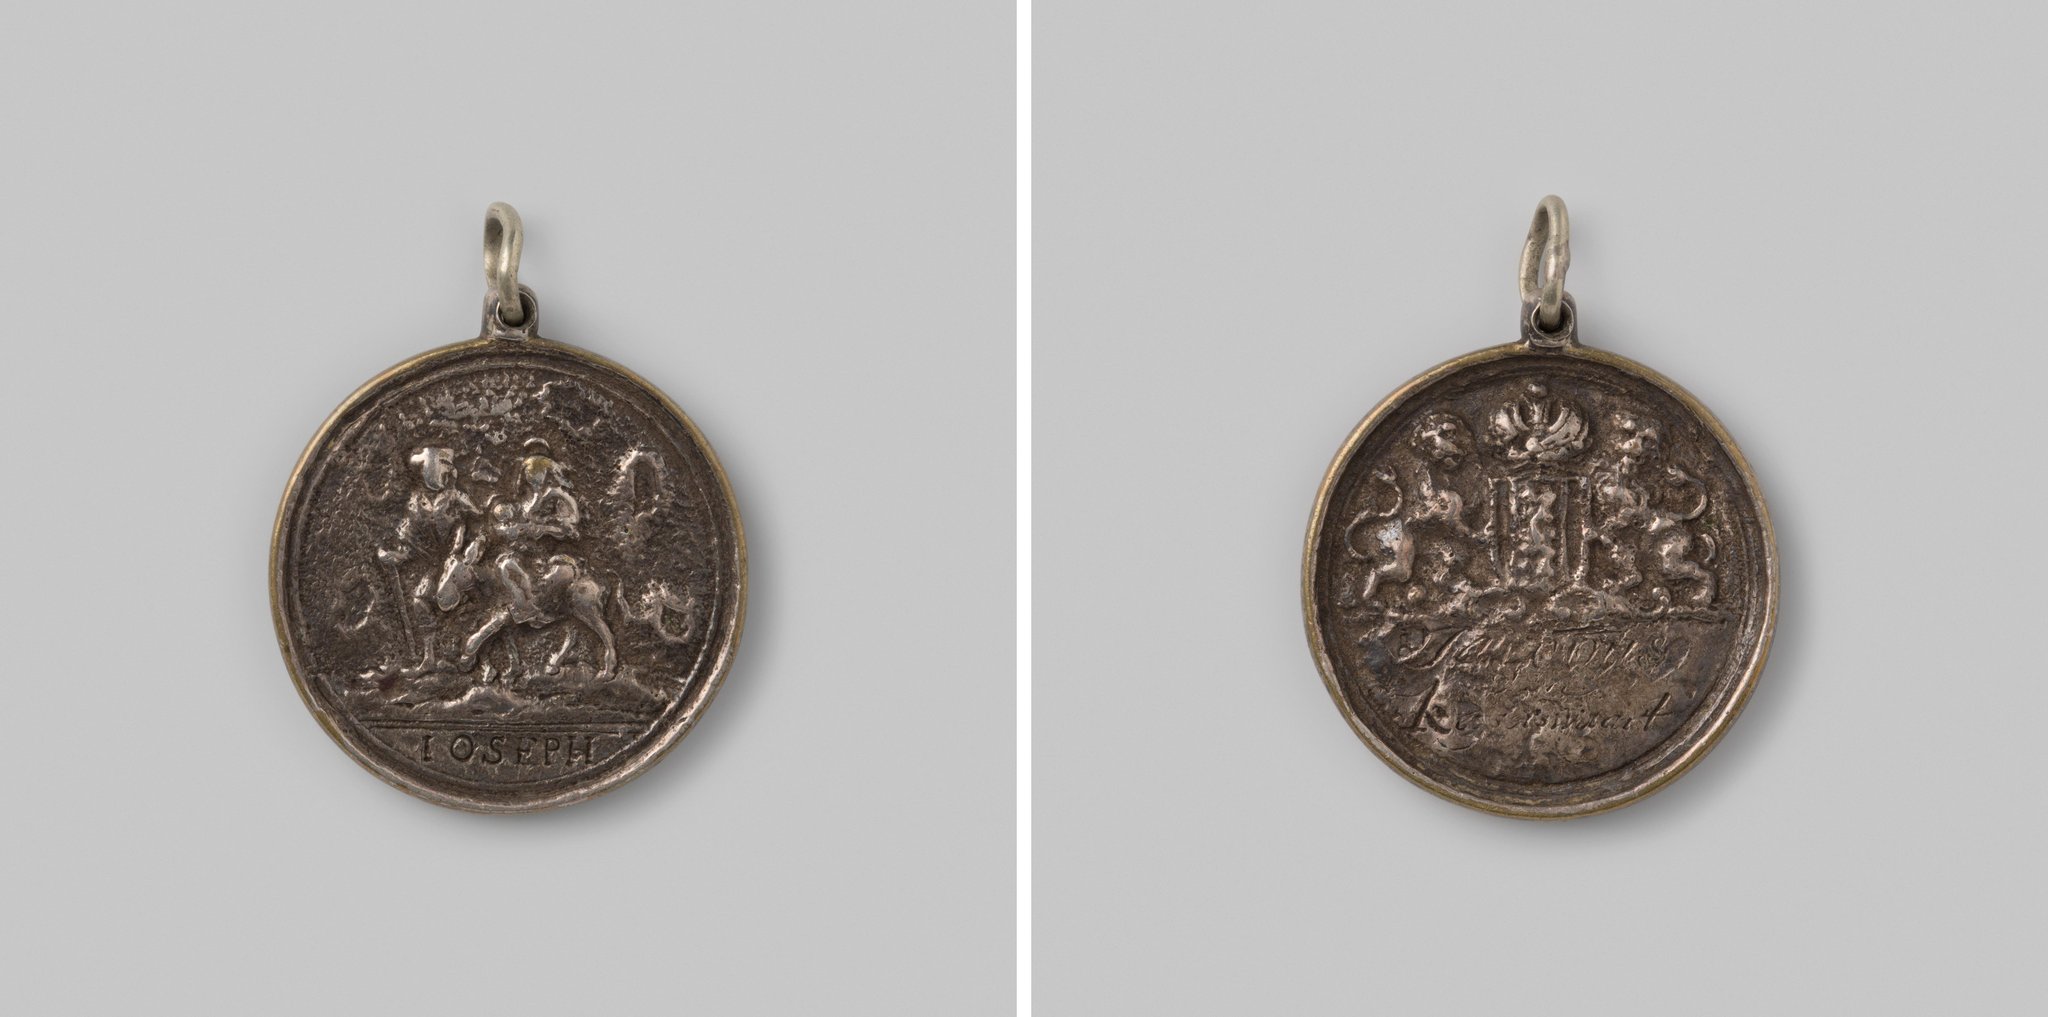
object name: history medal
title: Presentiepenning van het Sint Joseph- of Timmerliedengilde te Amsterdam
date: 1600-1800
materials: brass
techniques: casting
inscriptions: inscription: ‘Jacobus / Keyserswaart ??’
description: Gegoten messing penning met oog en draagring, verzilverd, op de voorzijde Joseph met stok en Maria met Jezus op ezel naar links, onderaan IOSEPH, op de keerzijde gekroond wapenschild van Amsterdam met dragers boven een inscriptieruimte, op naam van (inscriptie grotendeels weggekrast) Jacobus Keyserswaart